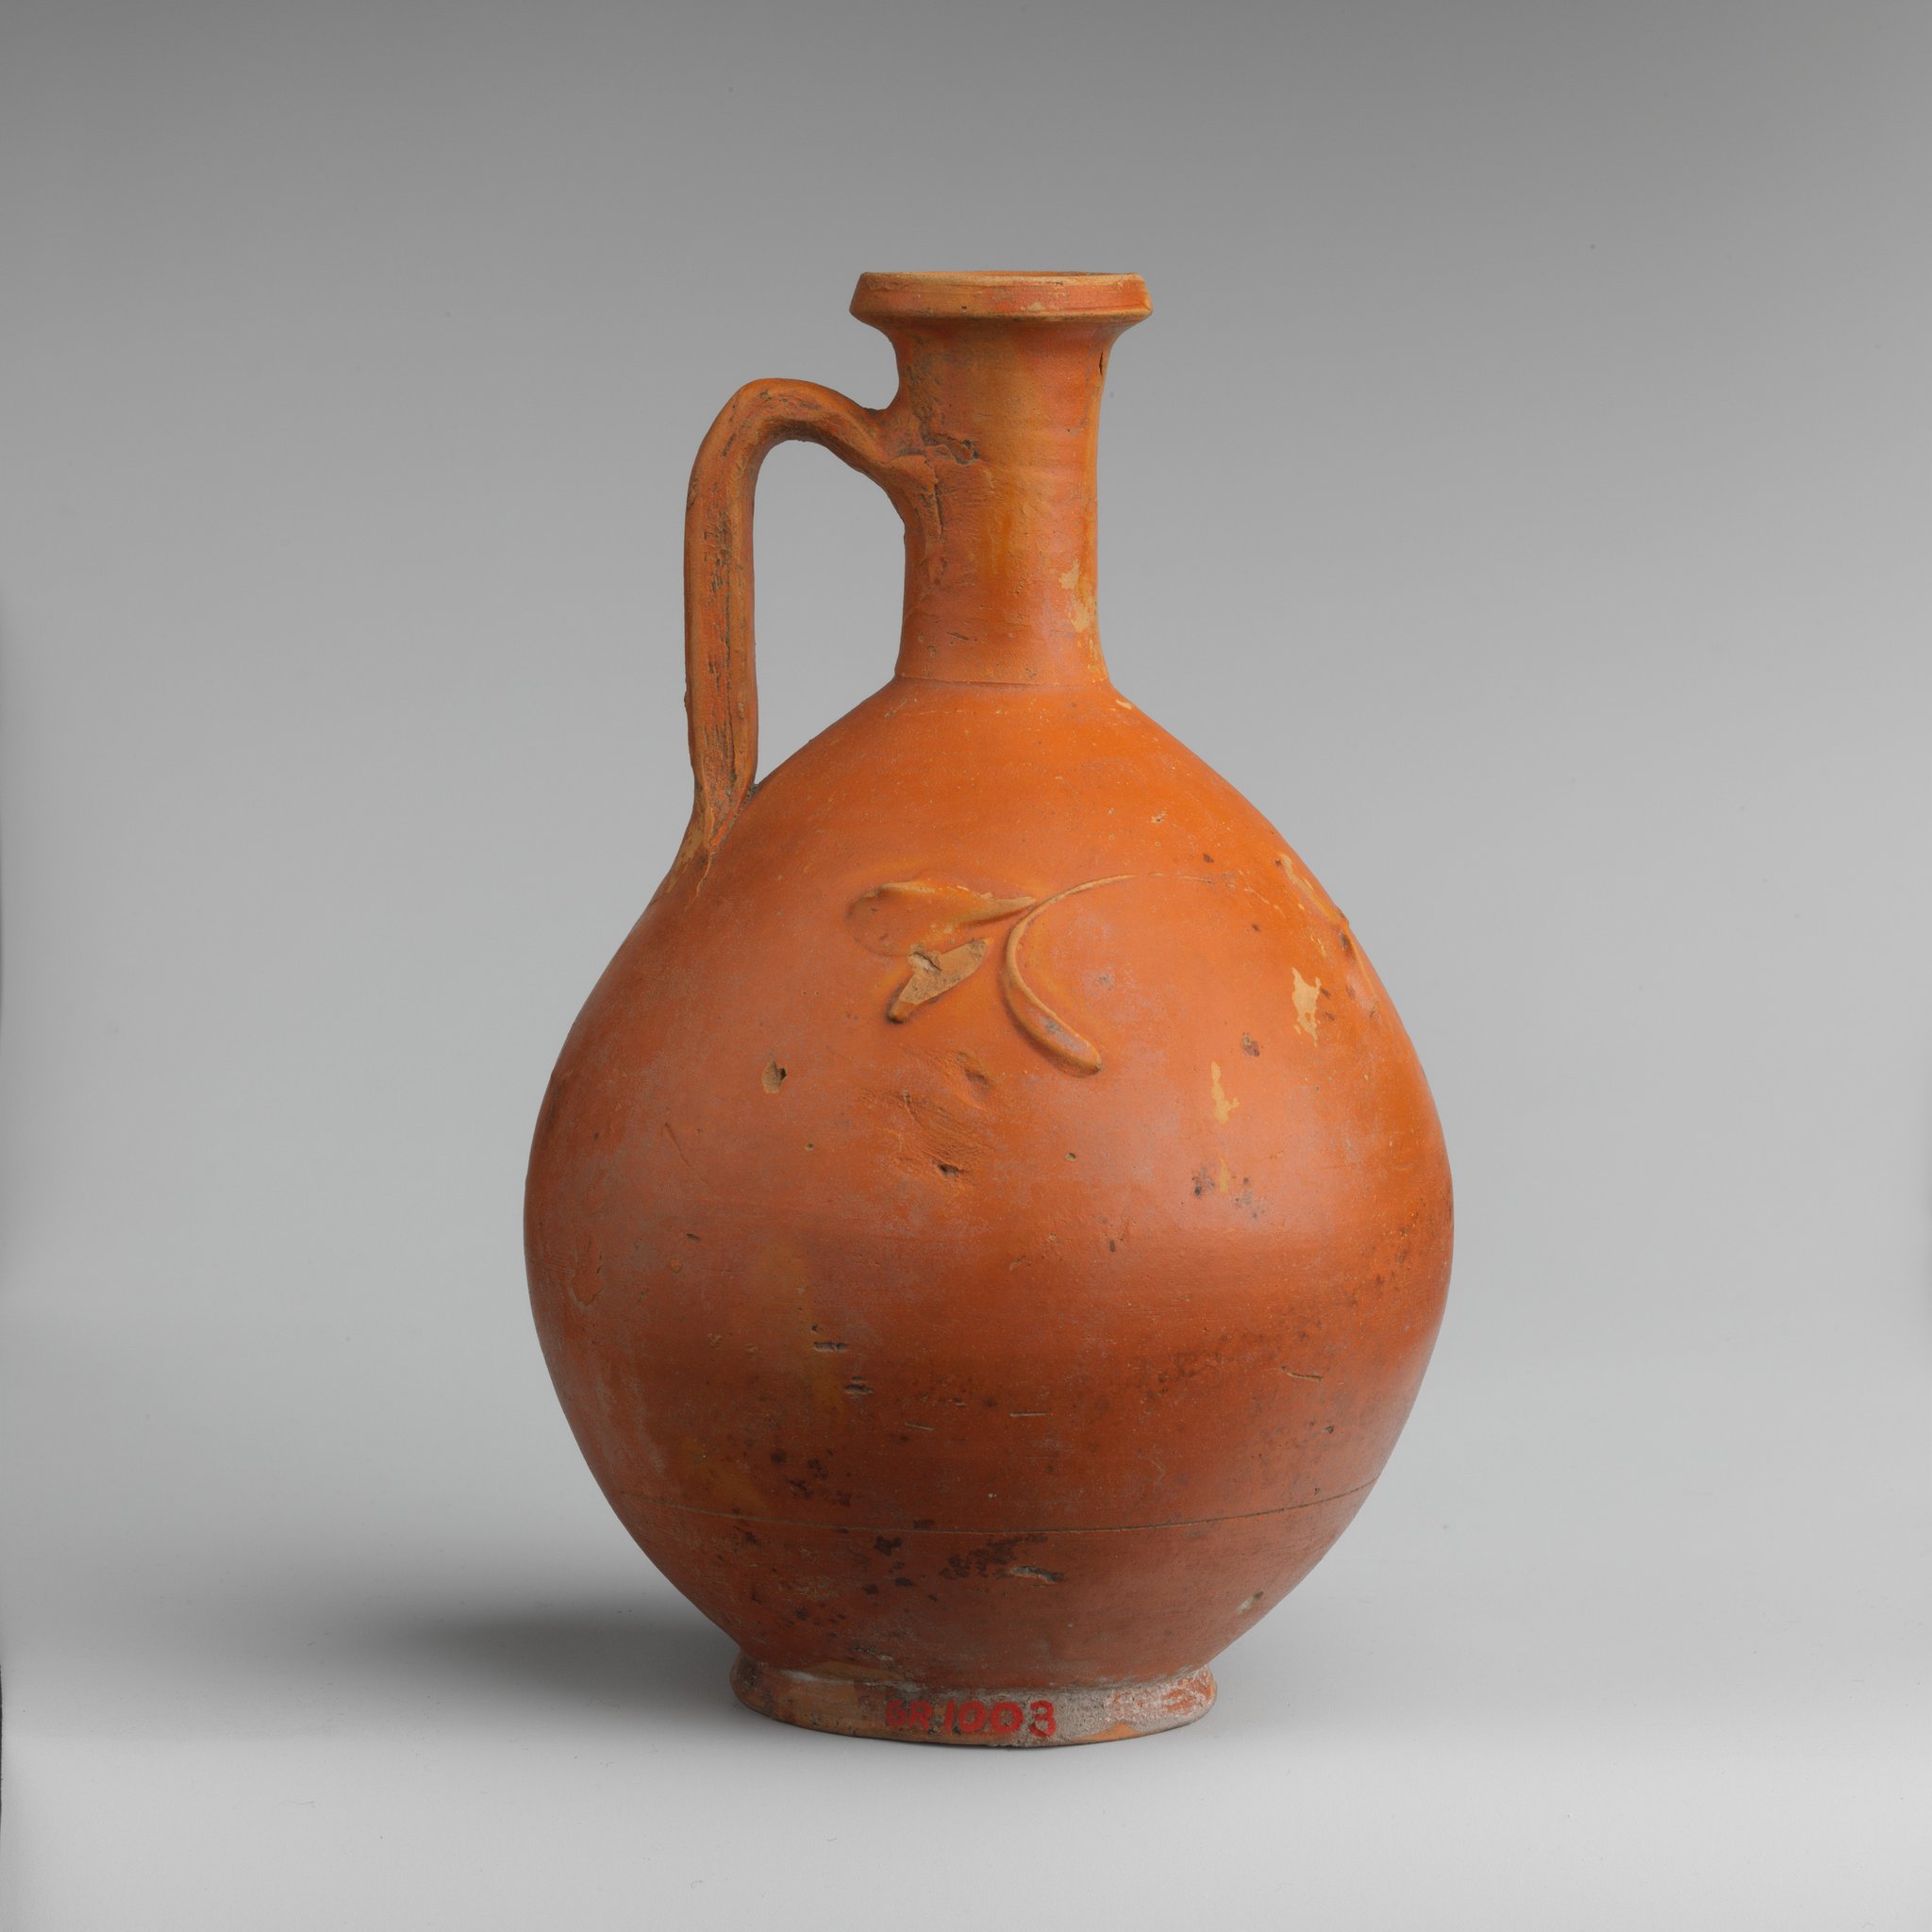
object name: jug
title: Terracotta jug with barbotine decoration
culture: roman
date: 1-100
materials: terracotta